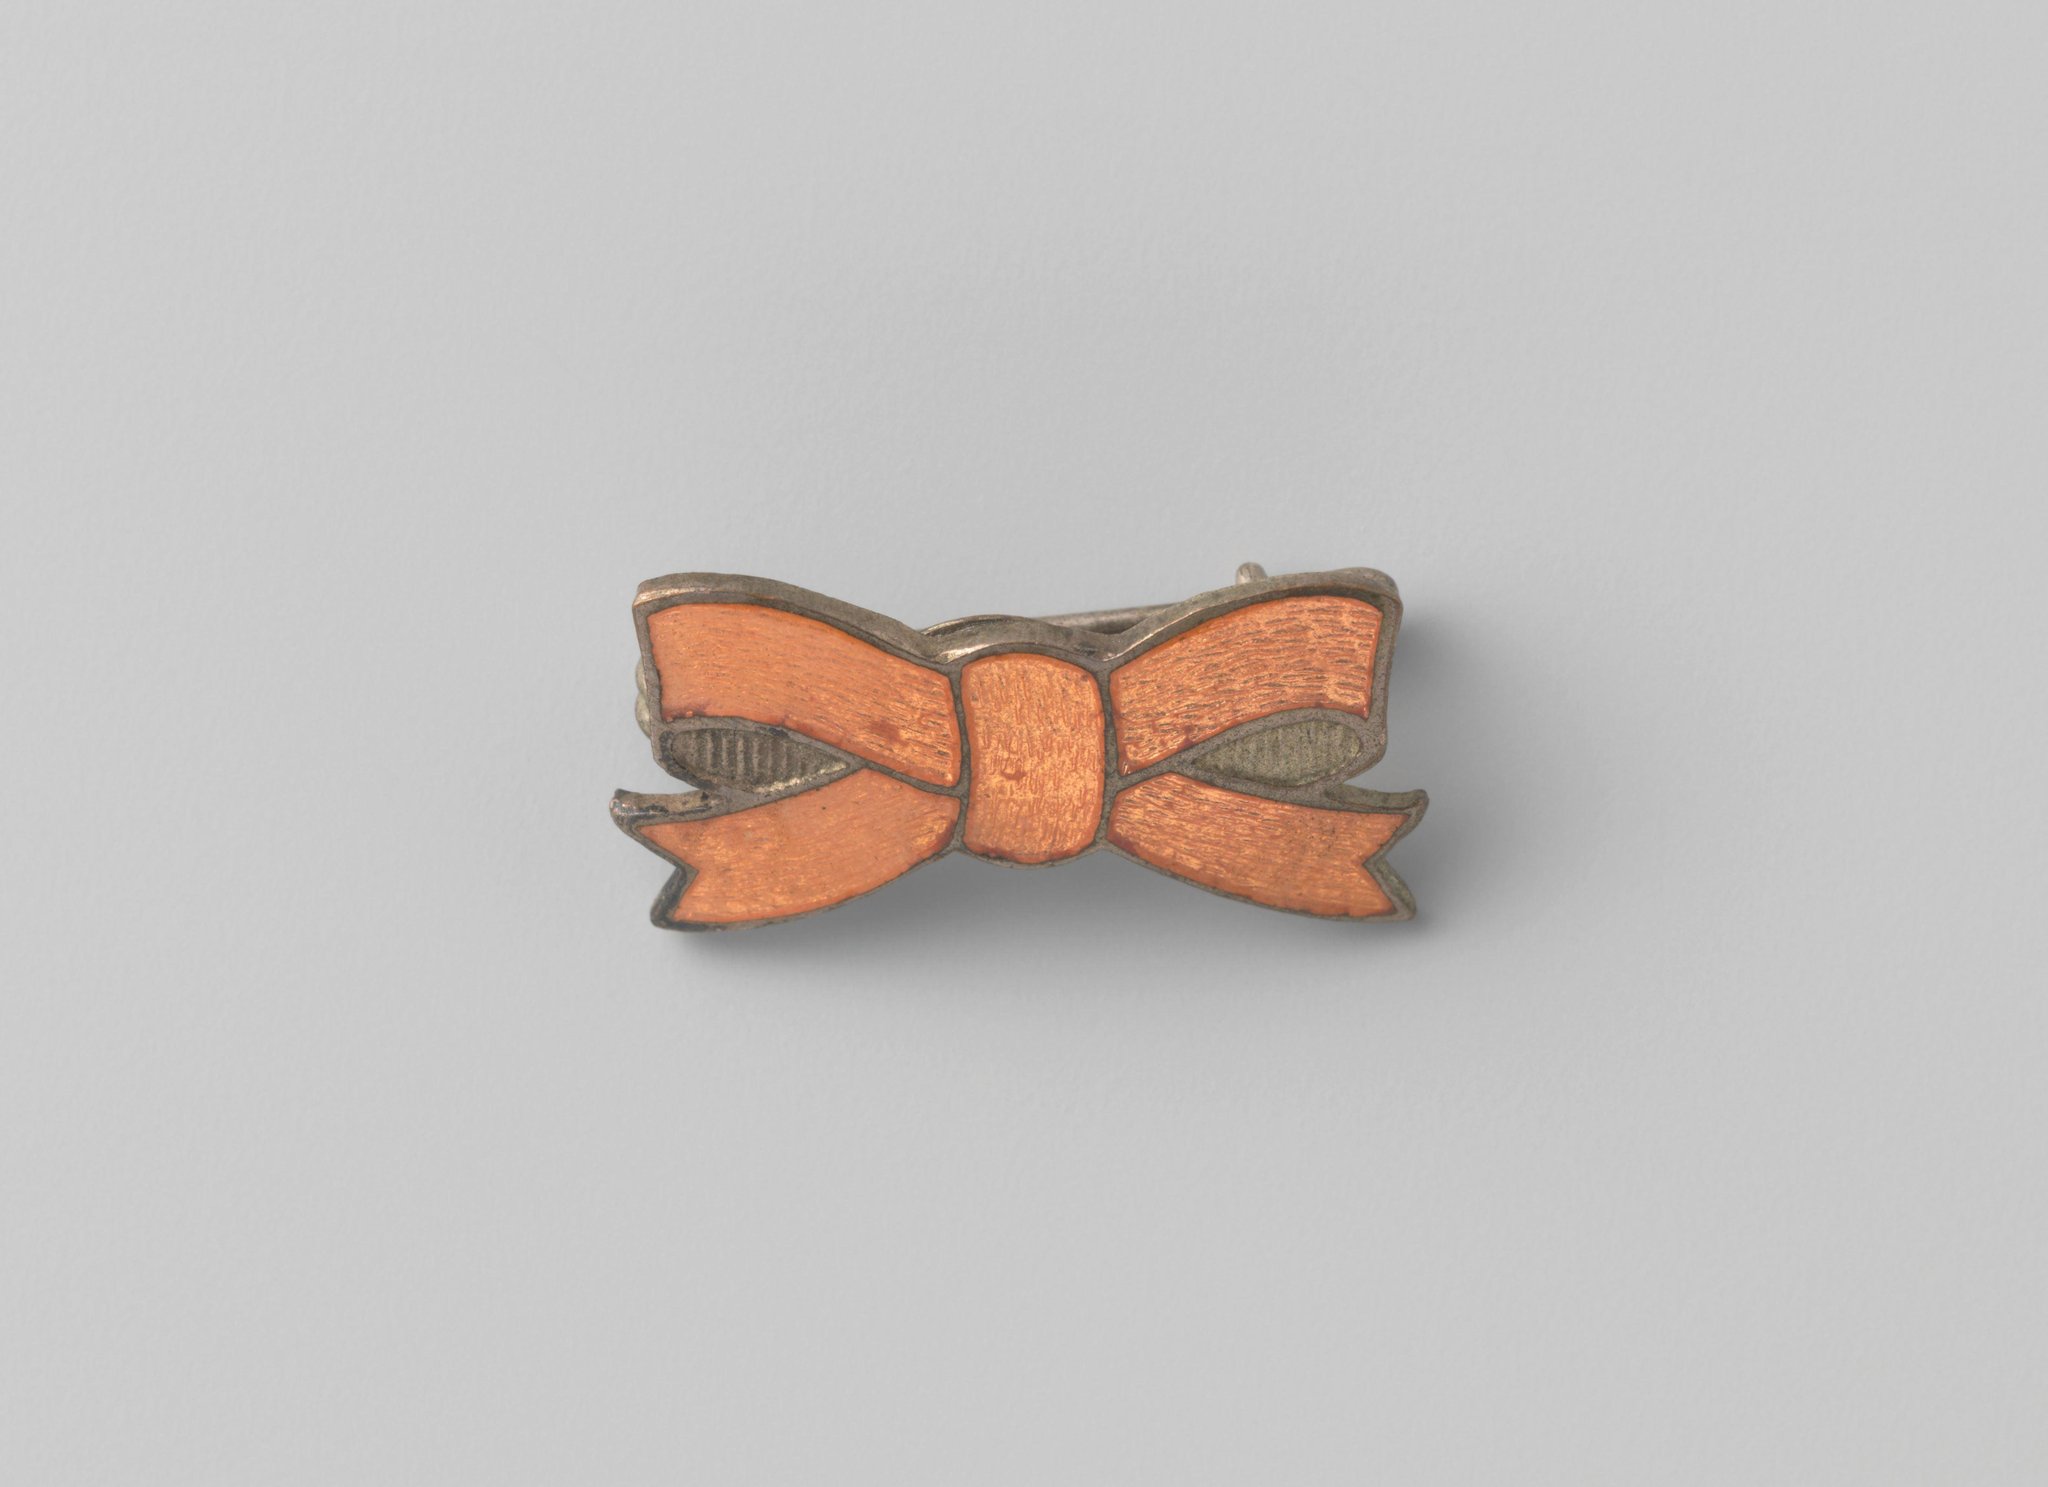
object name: brooch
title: Miscellaneous brooches and coin jewels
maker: Anonymous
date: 1945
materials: metal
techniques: enameling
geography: europe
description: Silent Resistance –War and Liberation Jewellery During the Second World War, small pieces of jewellery were worn in the Netherlands as a silent protest against the German occupier. In April 1941, Dutch coins were officially confiscated for the war industry. As jewellery did not have to be surrendered, coins were quickly transformed into rings, brooches, pins and bracelets. A portrait of Queen Wilhelmina was worn as a sign of resistance, as well as a token of loyalty to the royal family. Margriet Francisca, the third daughter of Princess Juliana and Prince Bernard, was born in Canada in January 1943. The pin with the three yellow chicks refers to the three young princesses Beatrix, Irene and Margriet and the steadfastness of the Dutch royal family. After the liberation, coins and silver were used for jewellery conveying messages of hope for a peaceful future.